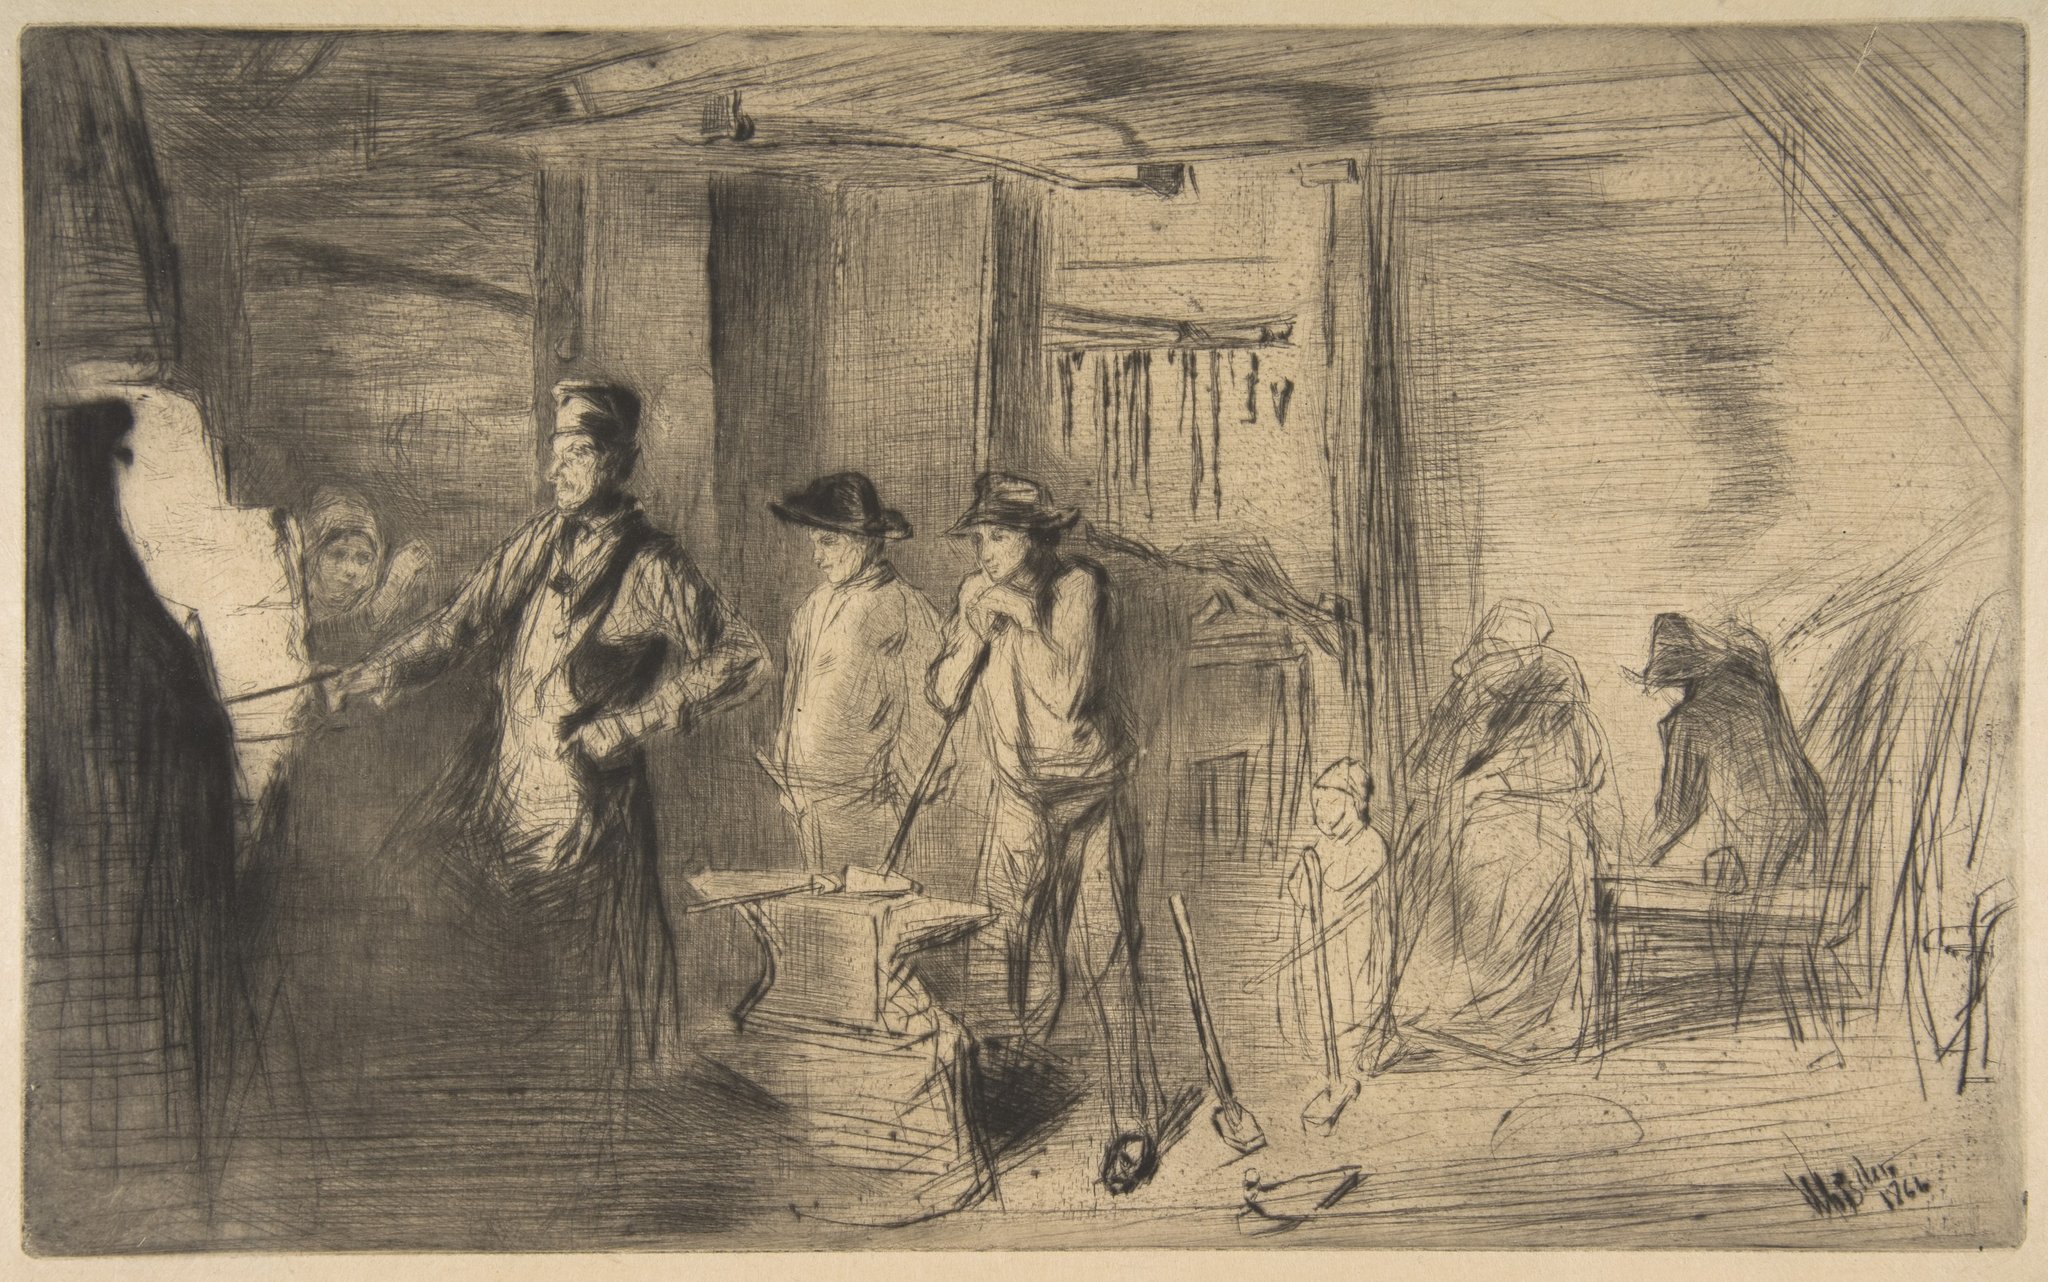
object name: print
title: The Forge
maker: james mcneill whistler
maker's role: artist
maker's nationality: american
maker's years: 1834-1903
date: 1861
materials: ink, paper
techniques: drypoint, printing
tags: men